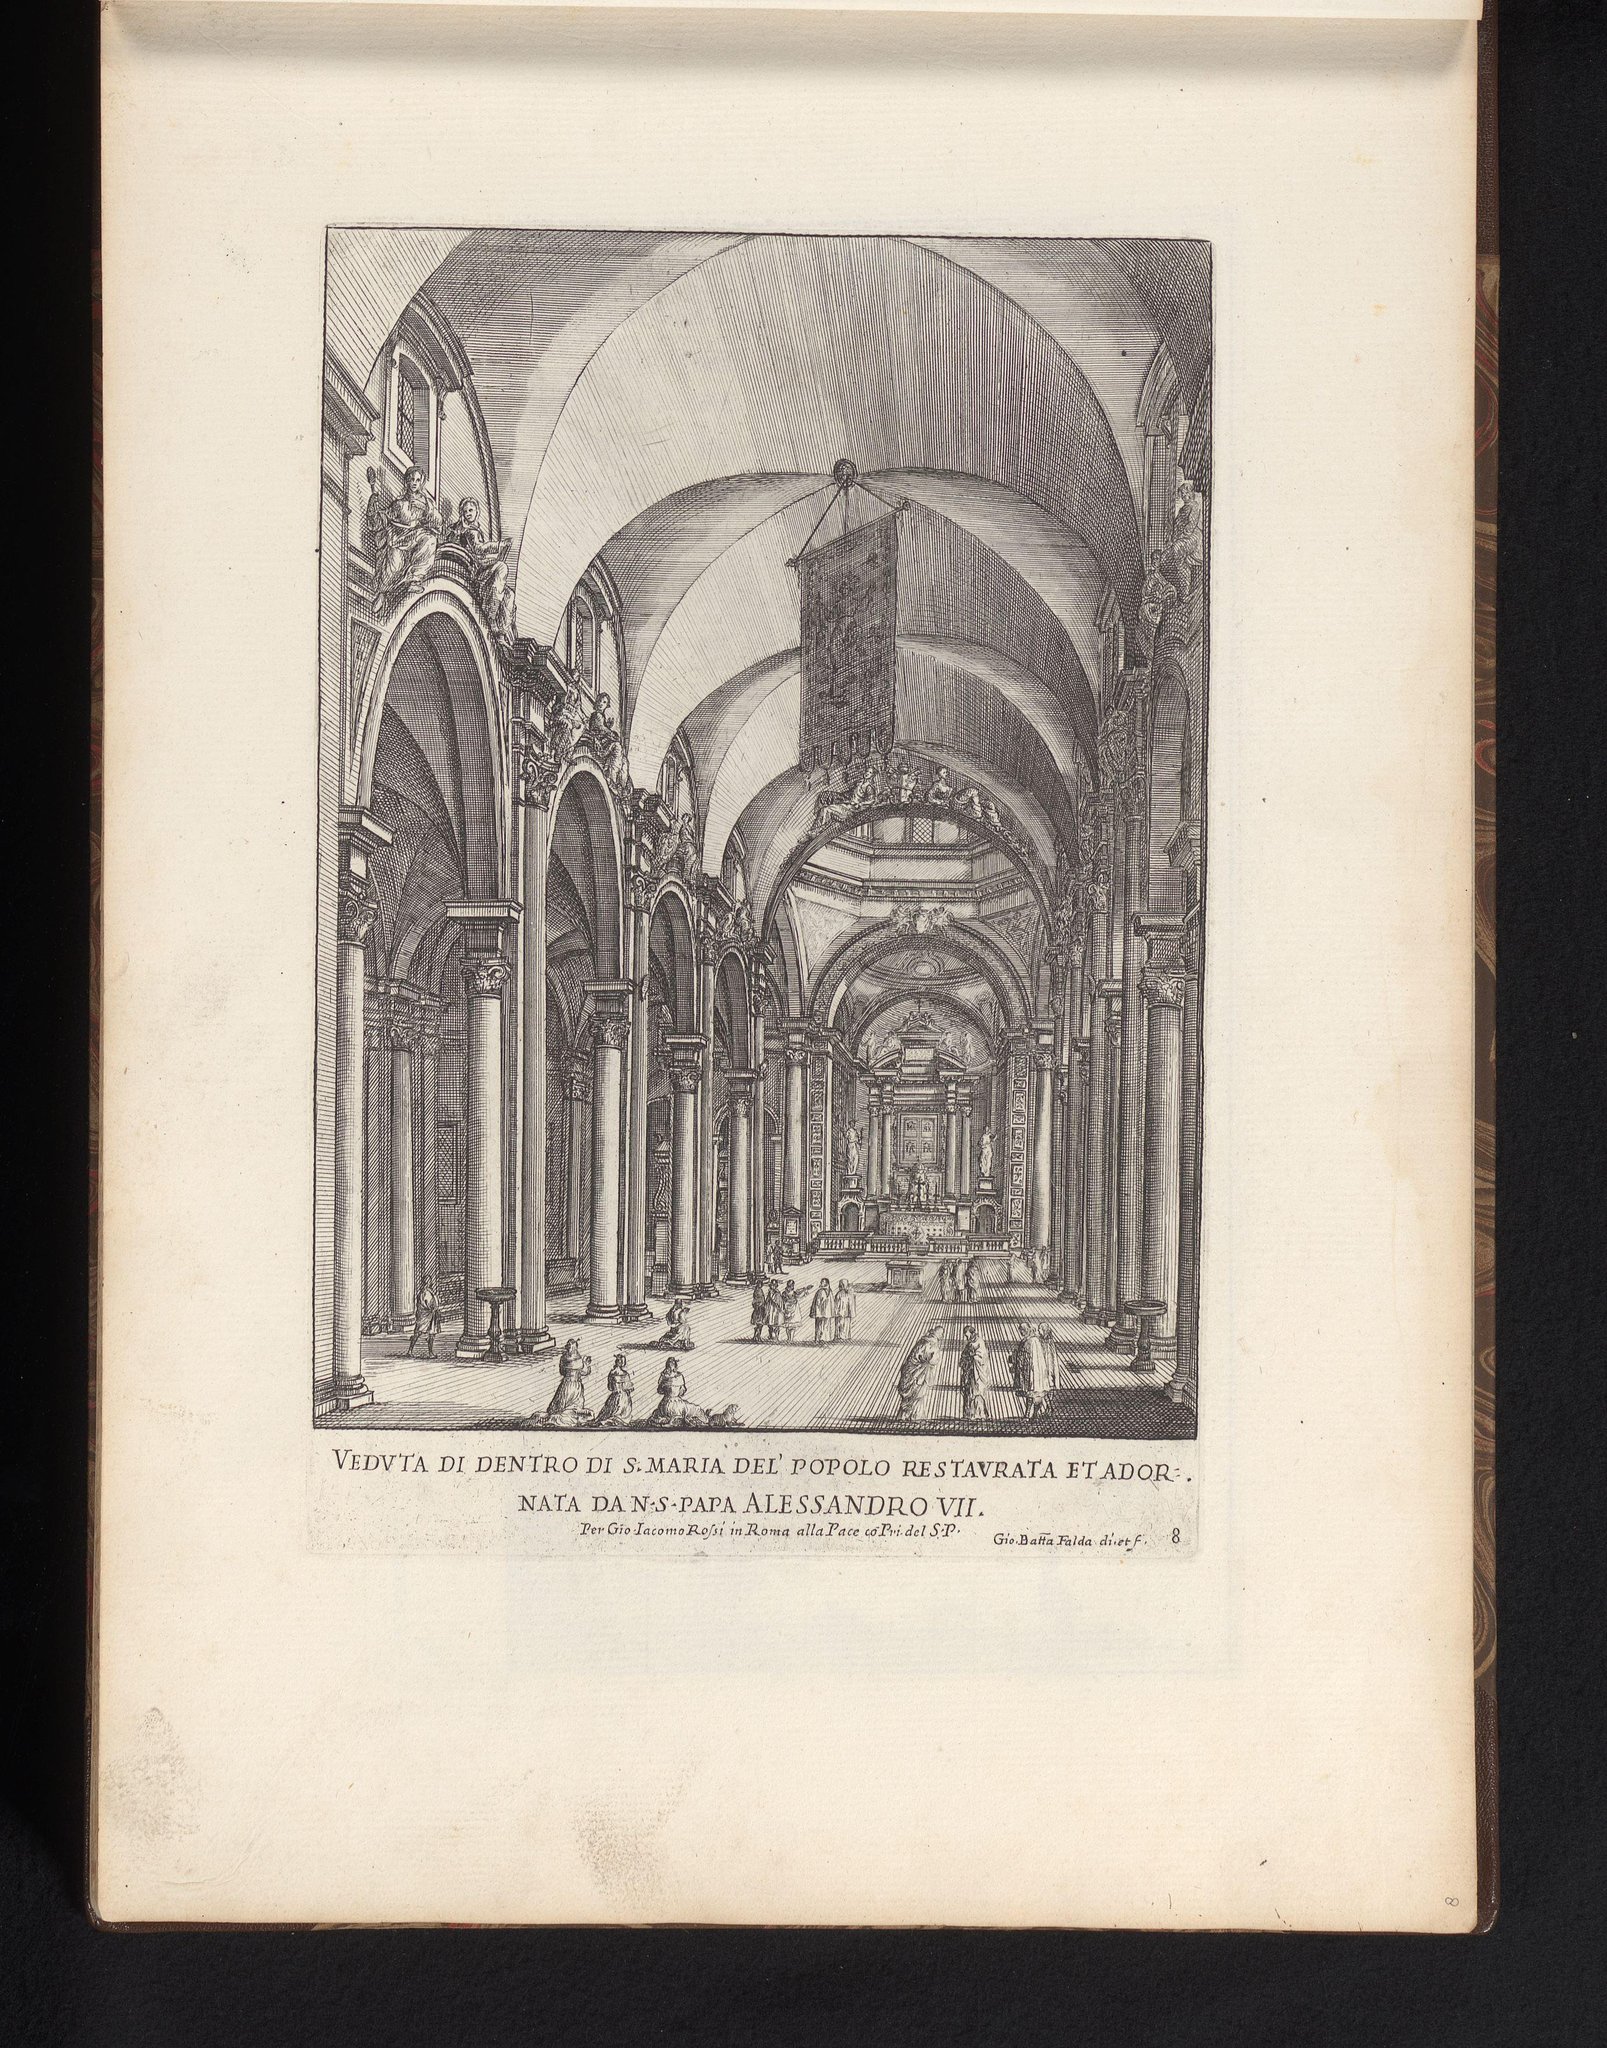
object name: album leaf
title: Il nuovo teatro di Roma moderna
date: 1665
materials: paper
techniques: etching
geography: rome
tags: interior of church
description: Deze prent maakt deel uit van een reeks van 35 prenten met voorstellingen van gebouwen in Rome. Samen met vier andere reeksen vormt het de grote reeks: 'Il nuovo teatro di Roma moderna'.